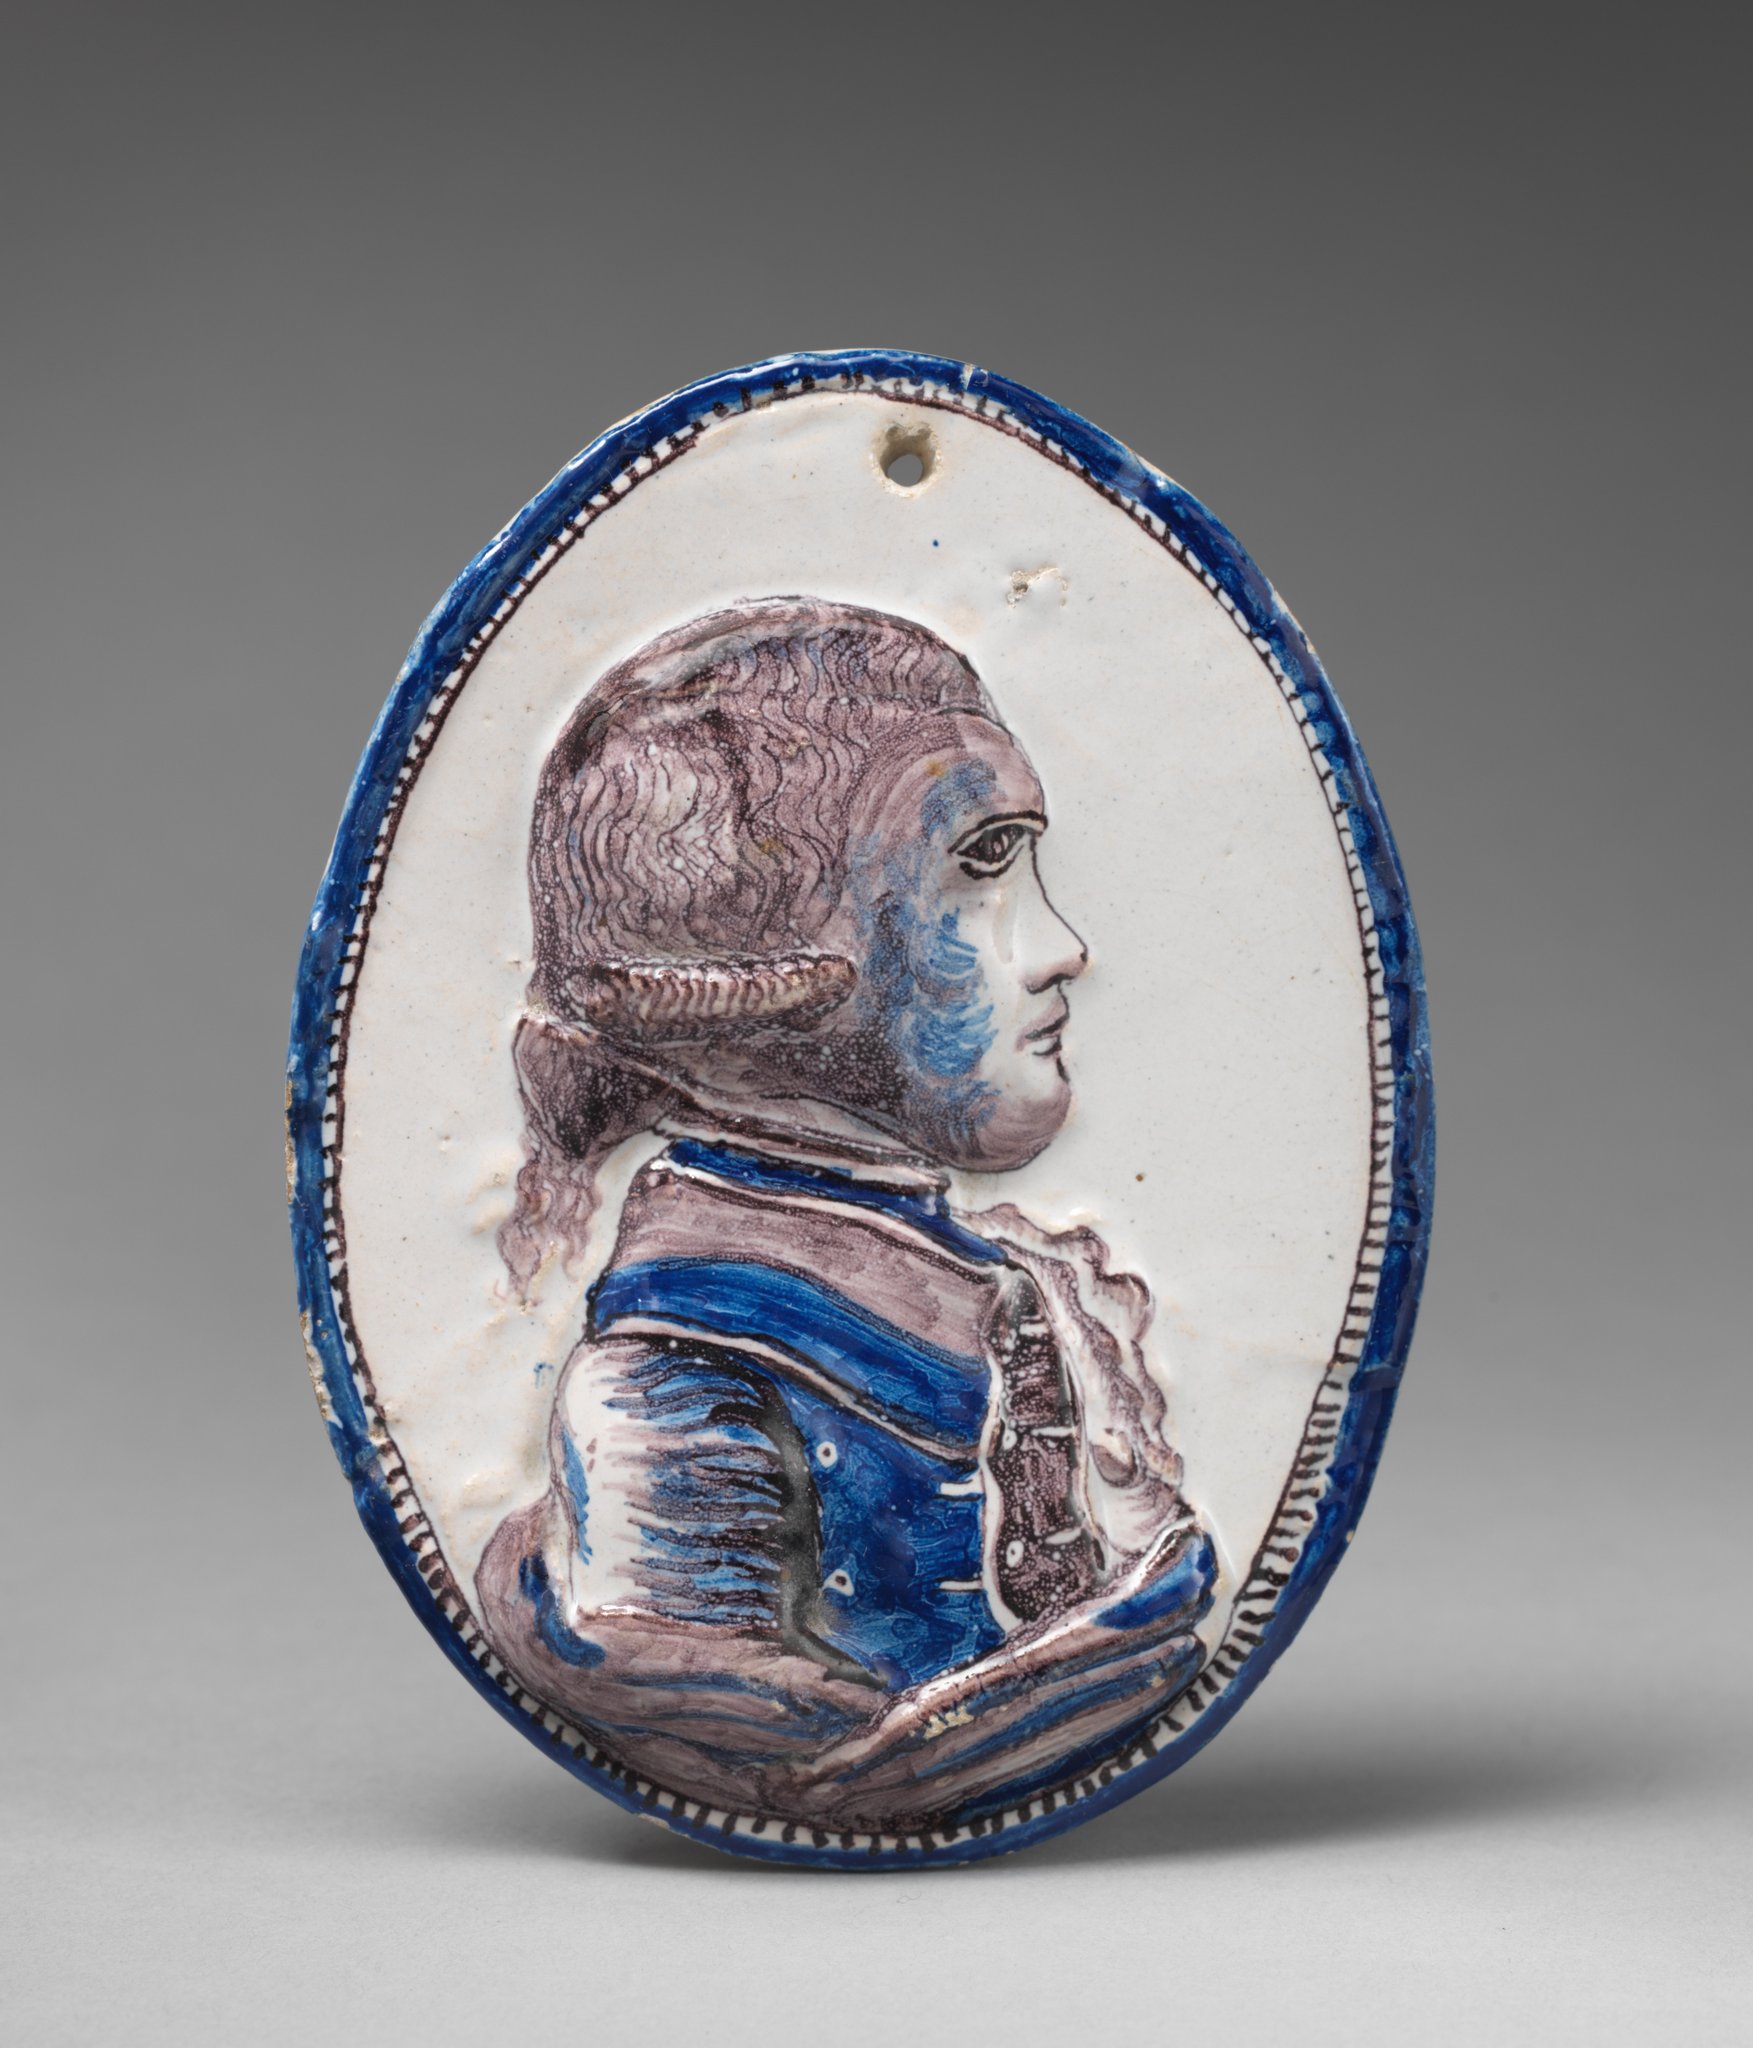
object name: medallion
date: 1801-1900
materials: earthenware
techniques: glazing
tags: men,portraits